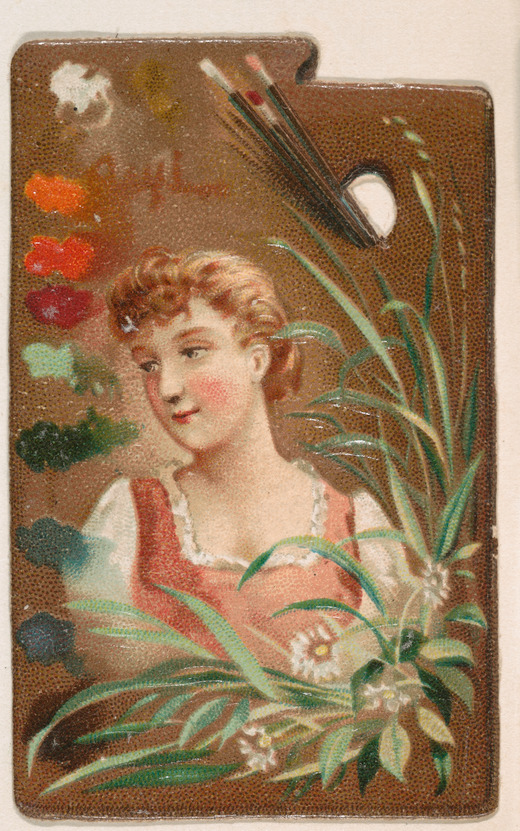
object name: print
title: Artist's paint pallette, from the Novelties series (N228, Type 4) issued by Kinney Bros.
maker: kinney brothers tobacco company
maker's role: publisher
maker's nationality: american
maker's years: 1869-2011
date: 1889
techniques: color lithograph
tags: women,flowers